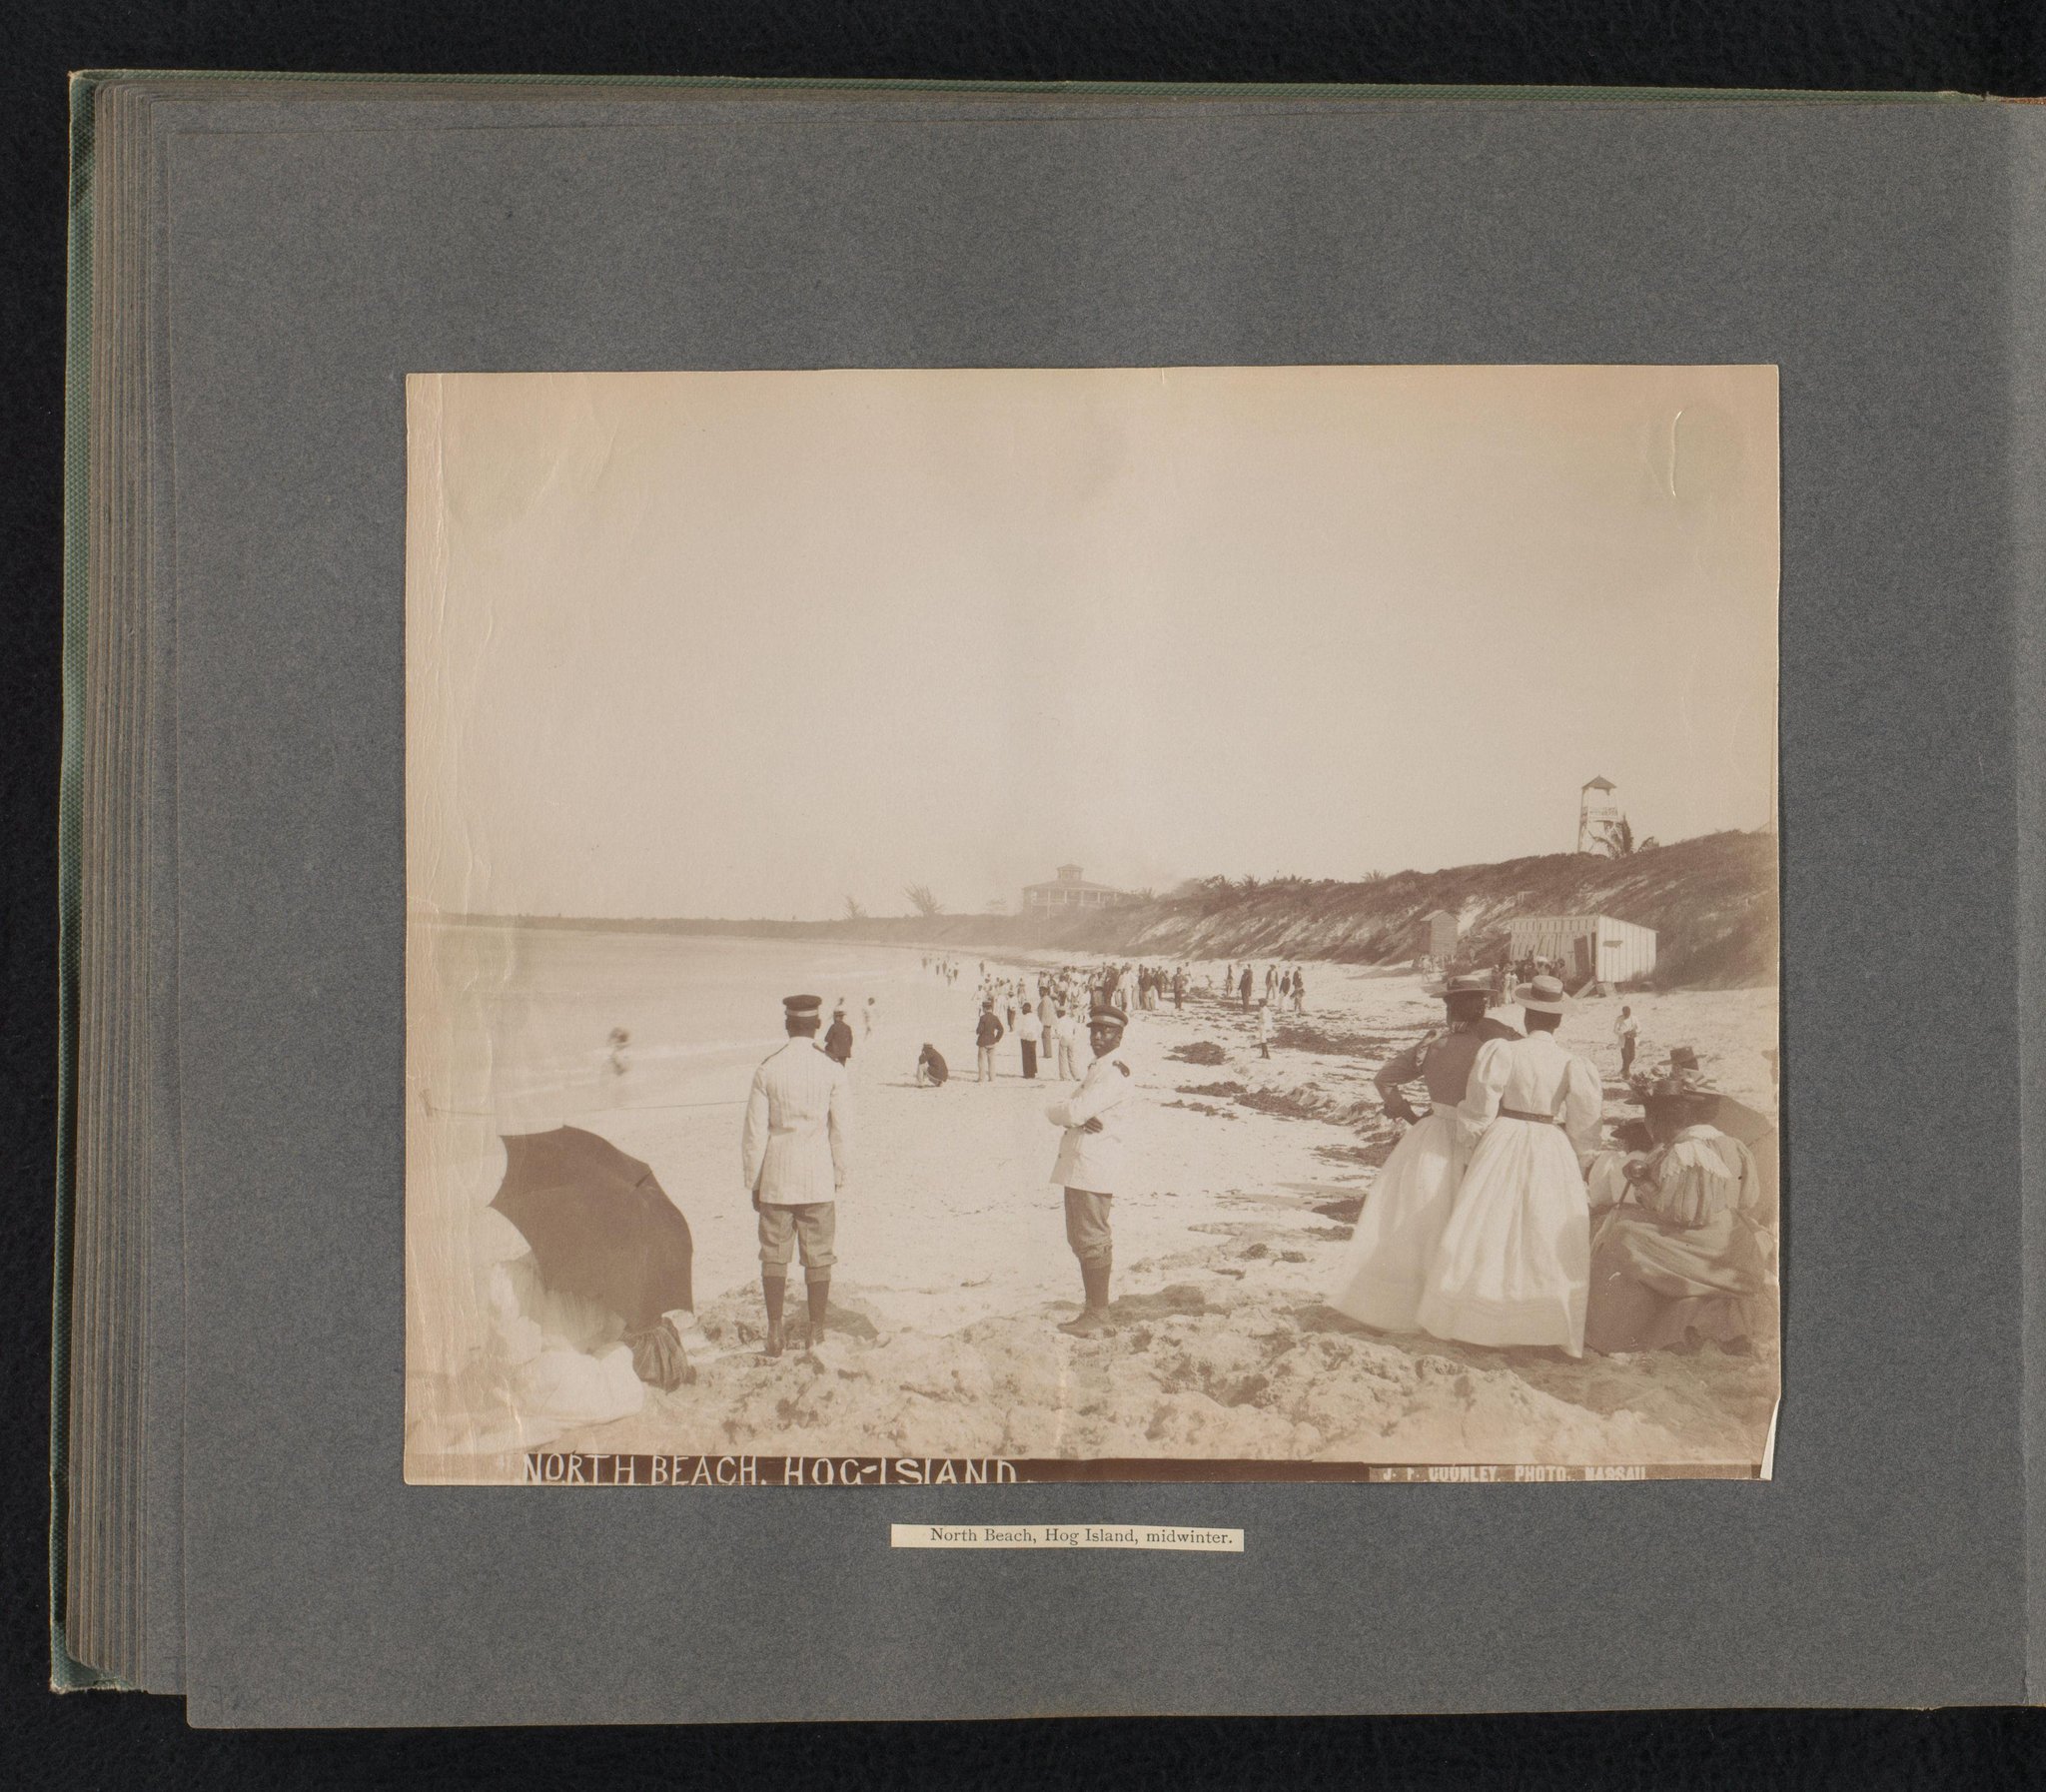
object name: photograph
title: North Beach. Hog-Island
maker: jacob frank coonley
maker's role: fotograaf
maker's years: 1832-1915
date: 1889-1895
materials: paper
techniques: albumen print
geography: paradise island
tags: beach (as place of recreation)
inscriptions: number: ‘41’